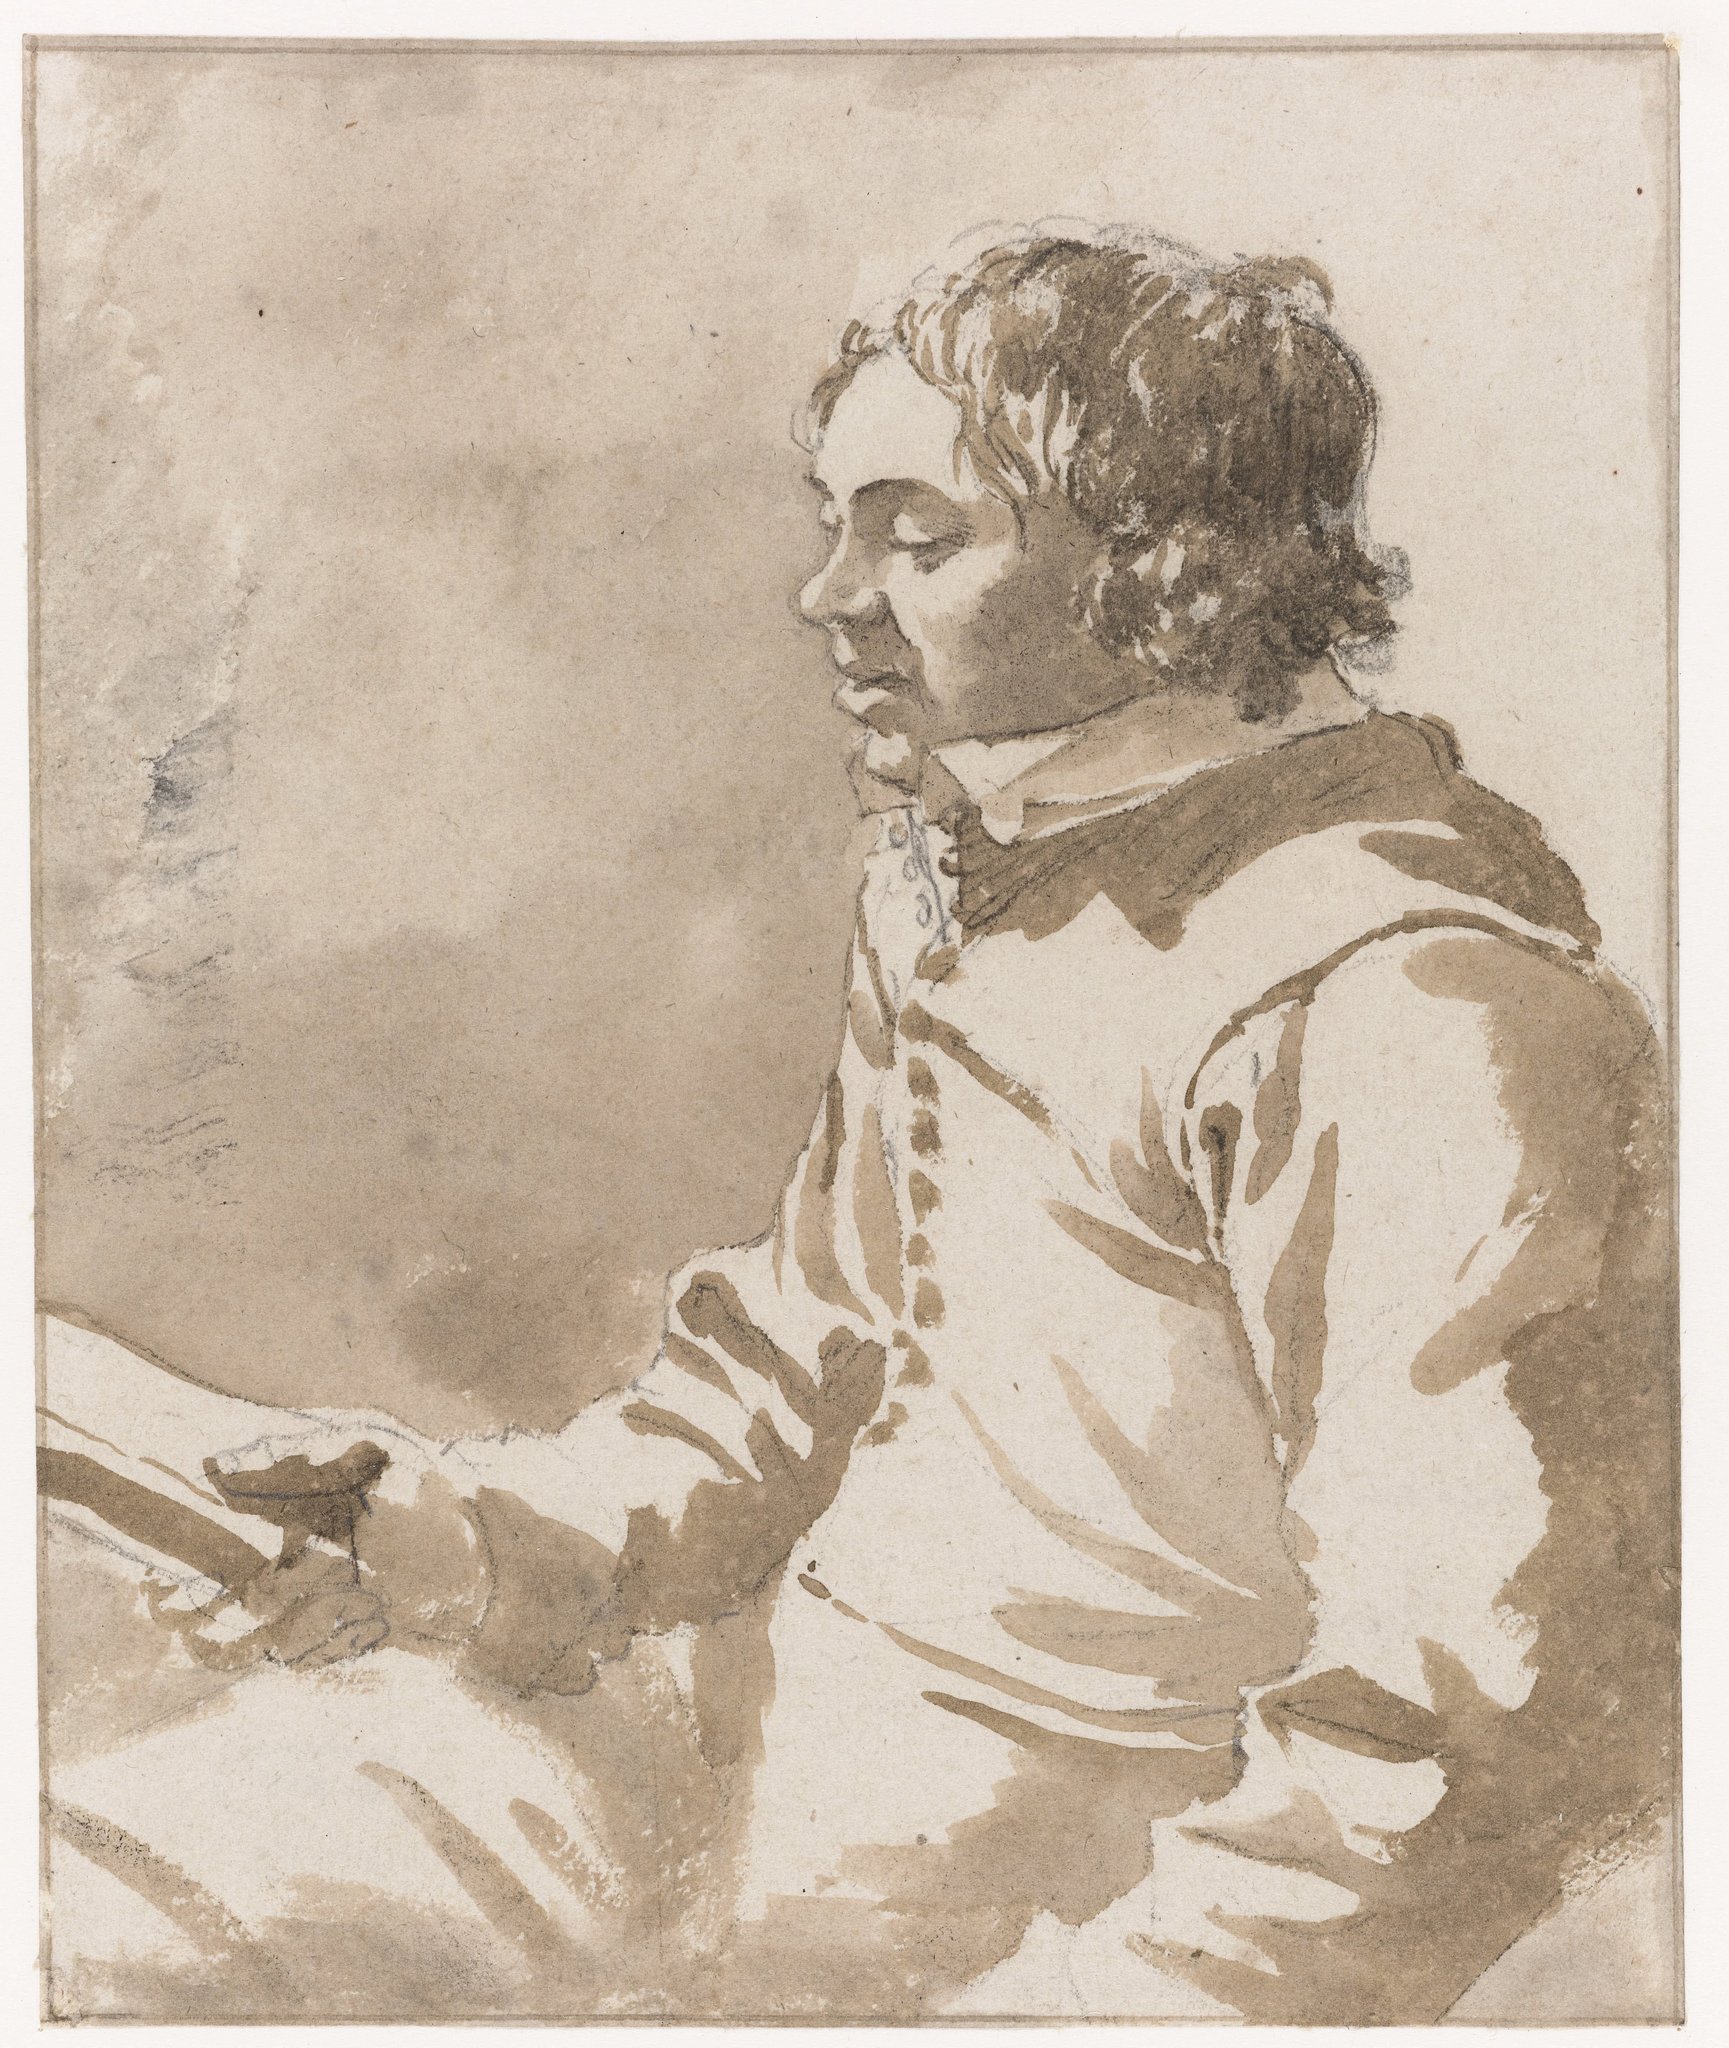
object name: drawing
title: Jacobus Ewijk, reading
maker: jan de bisschop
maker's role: draughtsman, print maker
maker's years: 1628-1671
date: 1648-1671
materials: chalk, paper, pencil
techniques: brush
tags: historical persons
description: Although De Bisschop excelled in portraits drawn from life, he made only a few of them. Thanks to the inscription on the back of this drawing, the sitter can be identified as Jacobus van Ewijk. His father was a clergyman in the small town of Woerden, near Leiden. De Bisschop and Van Ewijk may have met while studying in Leiden.